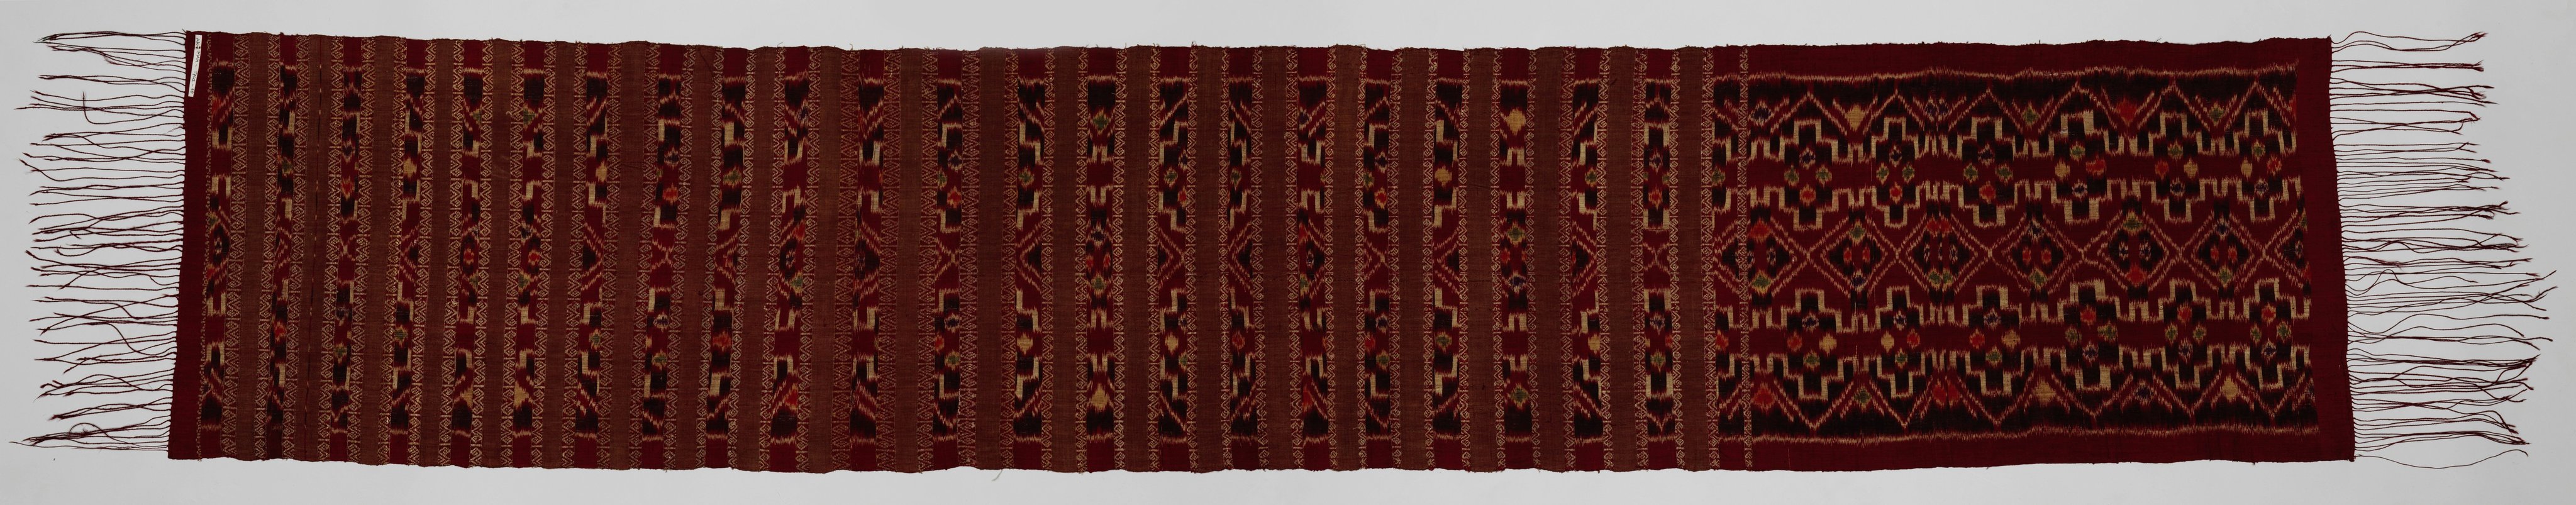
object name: schouderdoek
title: Selandang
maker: Anonymous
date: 1900-1949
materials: silk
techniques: weave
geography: bali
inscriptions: label